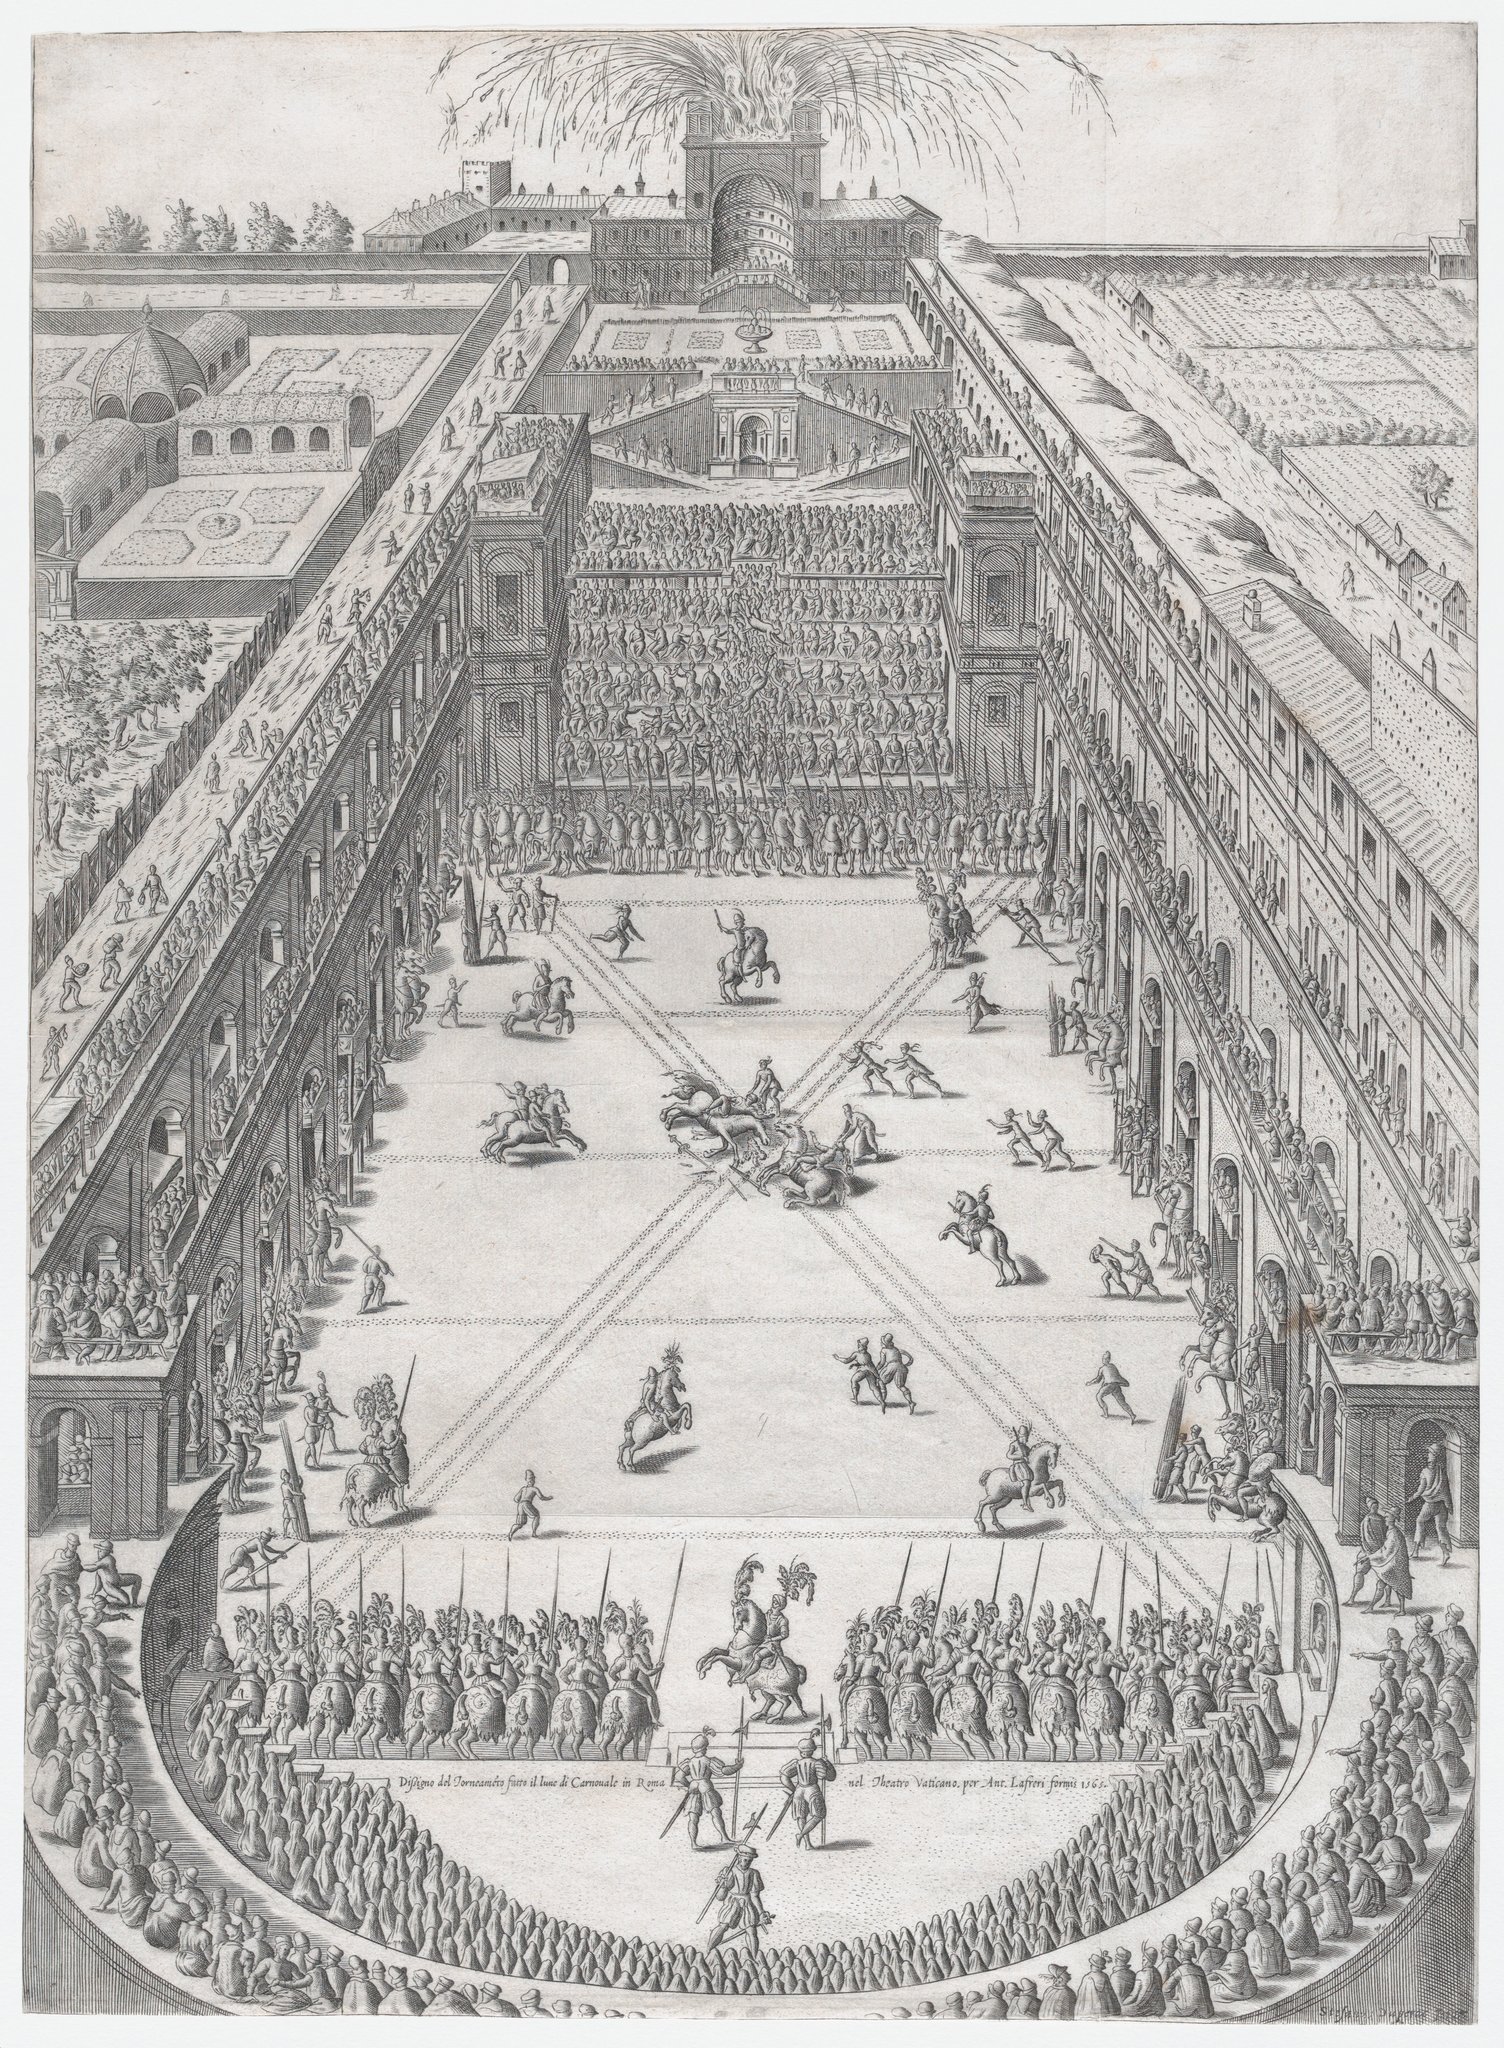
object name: print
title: Marriage of Annibale Altemps and Ortensia Borromeo, Rome, March 5, 1565, from "Speculum Romanae Magnificentiae"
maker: etienne dupérac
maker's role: artist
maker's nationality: french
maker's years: 1535-1604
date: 1565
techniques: engraving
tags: courtyards,soldiers,horses,crowd,rome